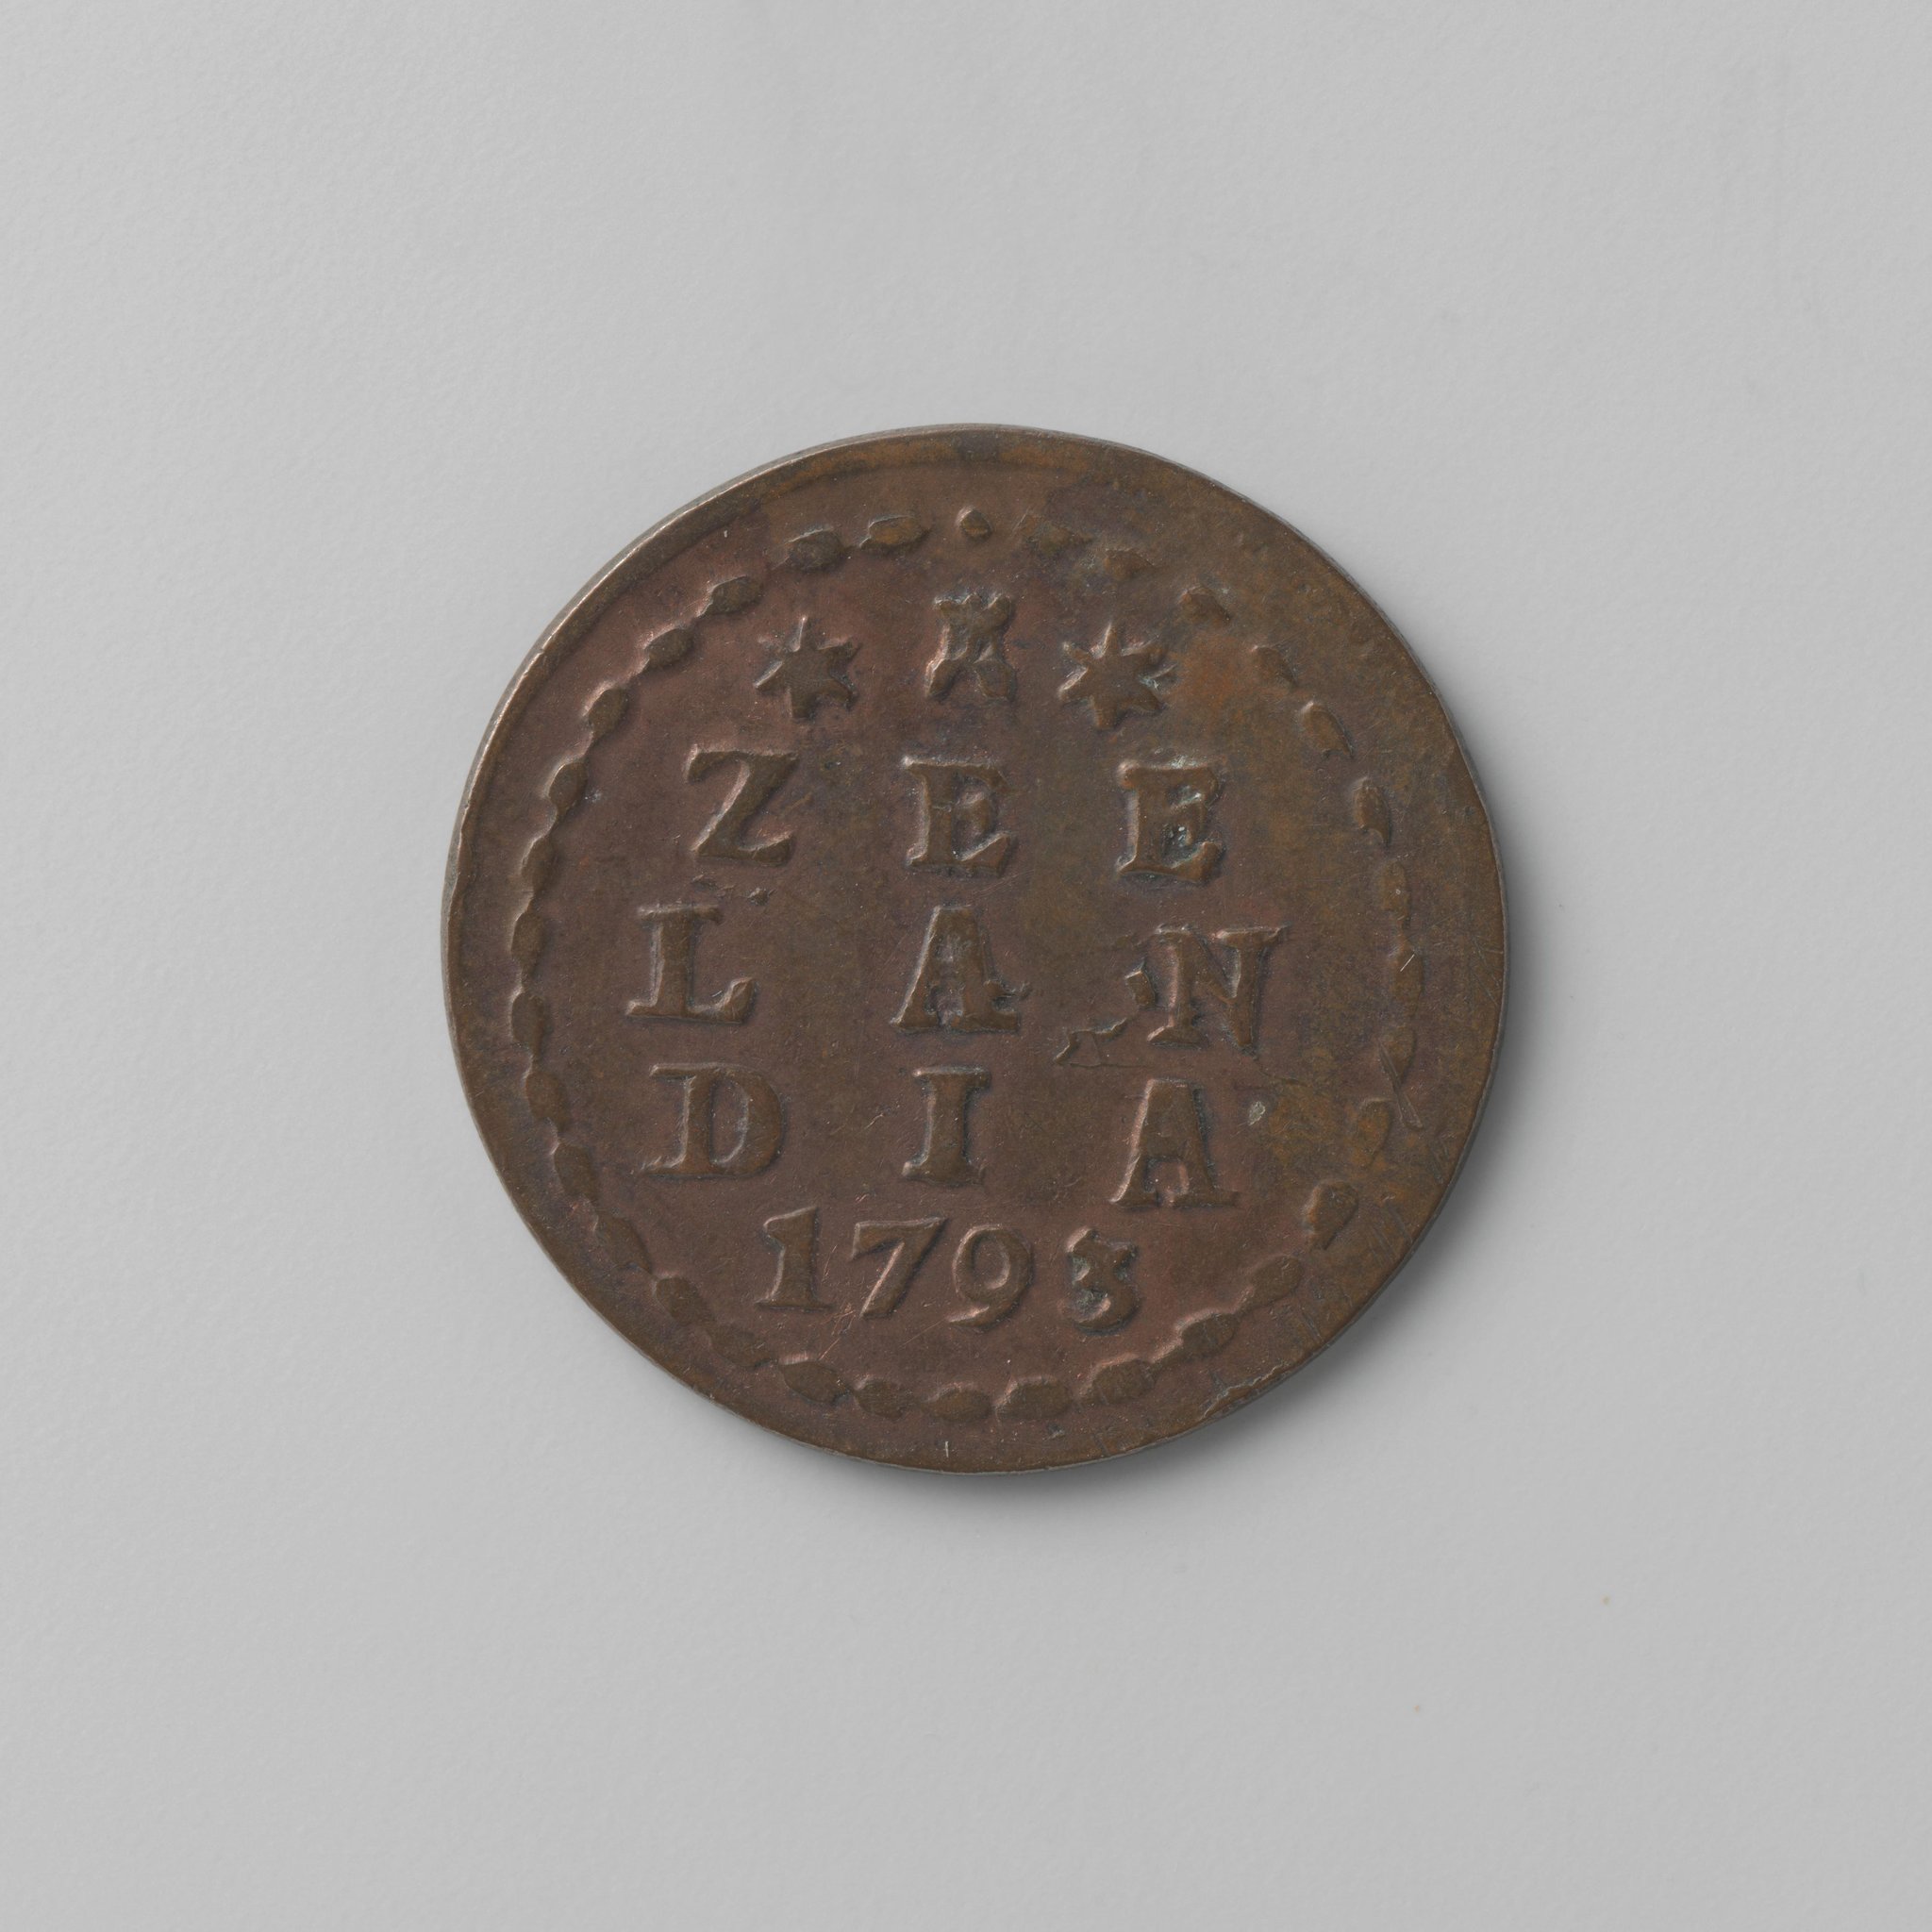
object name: coin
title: Zeeuwse duit, 1793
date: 1793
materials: copper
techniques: striking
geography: middelburg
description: Koperen munt. Voorzijde: gekroond, zijdelings ingedeukt wapenschild van Zeeland. Keerzijde: in een krans opschrift in drie regels, waarboven muntteken burcht tussen twee sterren en waaronder jaartal.